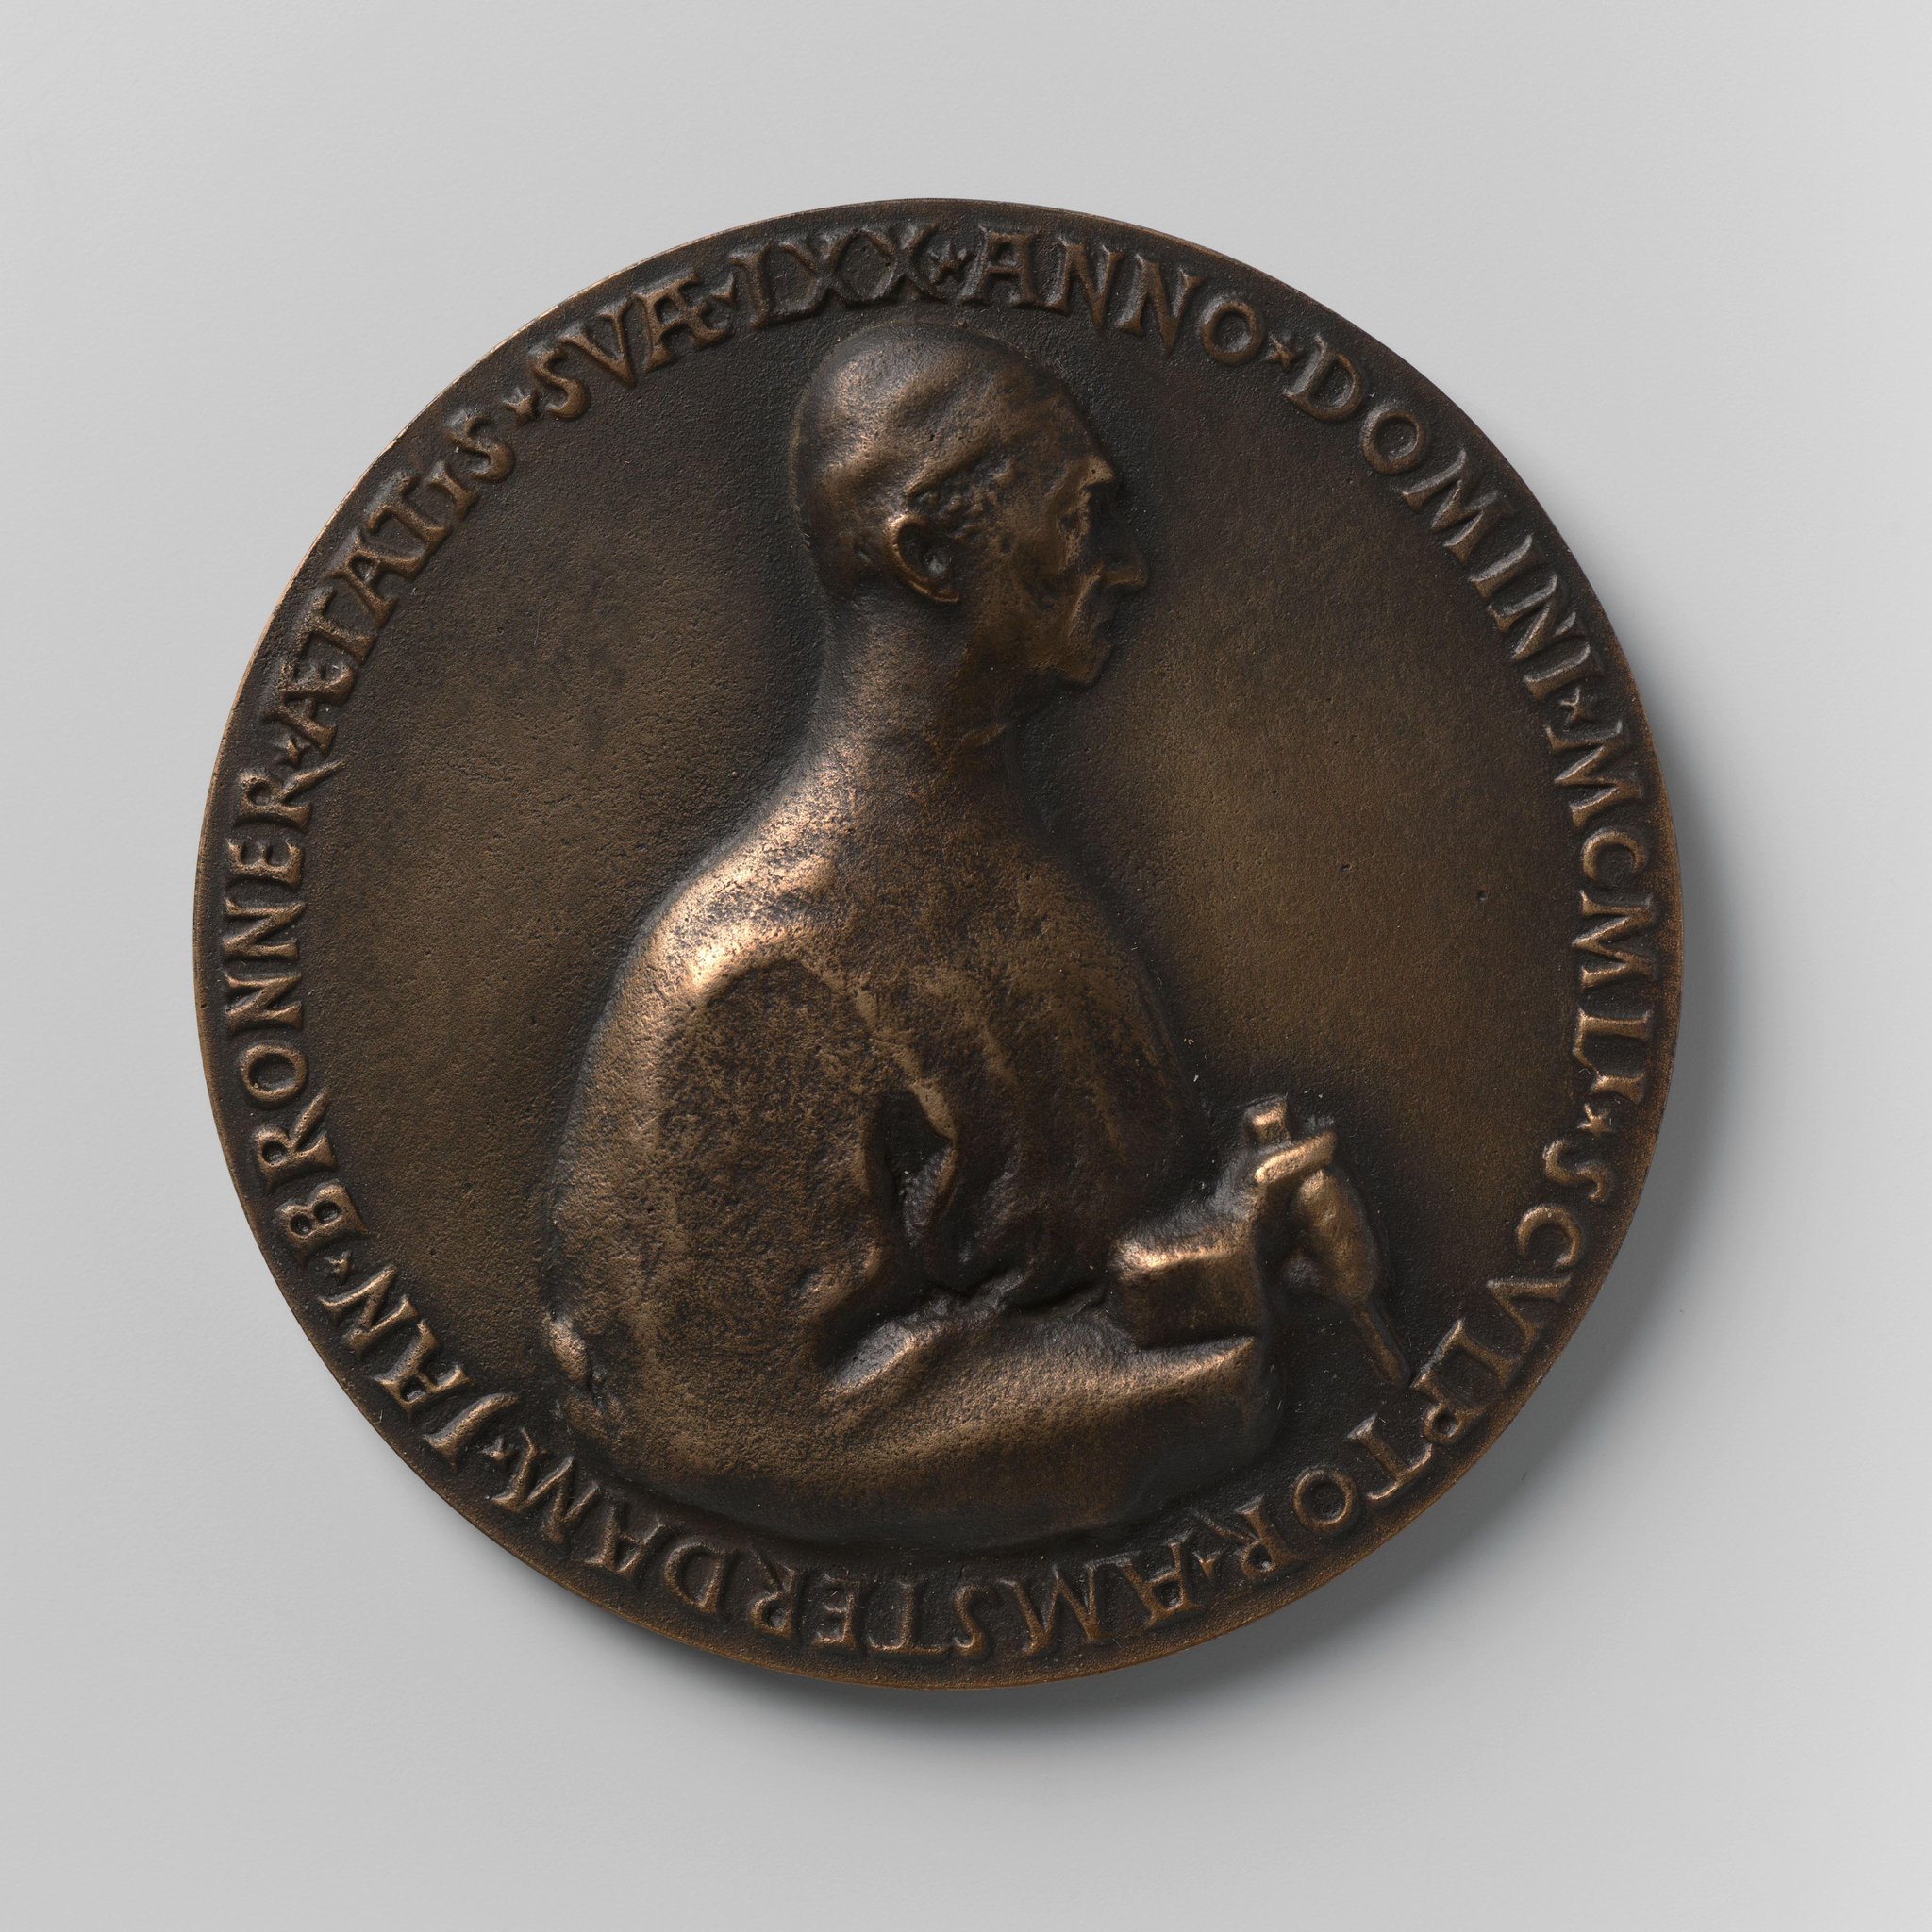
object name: medal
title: Zeventigste verjaardag van professor Jan Bronner (Vereniging voor Penningkunst 1952, tweede penning)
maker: vincent pieter semeyn esser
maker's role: hoogleraar, medailleur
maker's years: 1914-2004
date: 1952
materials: bronze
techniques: casting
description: Bronzen penning, op de voorzijde Bronner ten halven lijve in werkkleding met hamer en beitel, met omschrift, op de keerzijde de beeldhouwer en zijn leerling aan het werk, met omschrift, met verklaring.